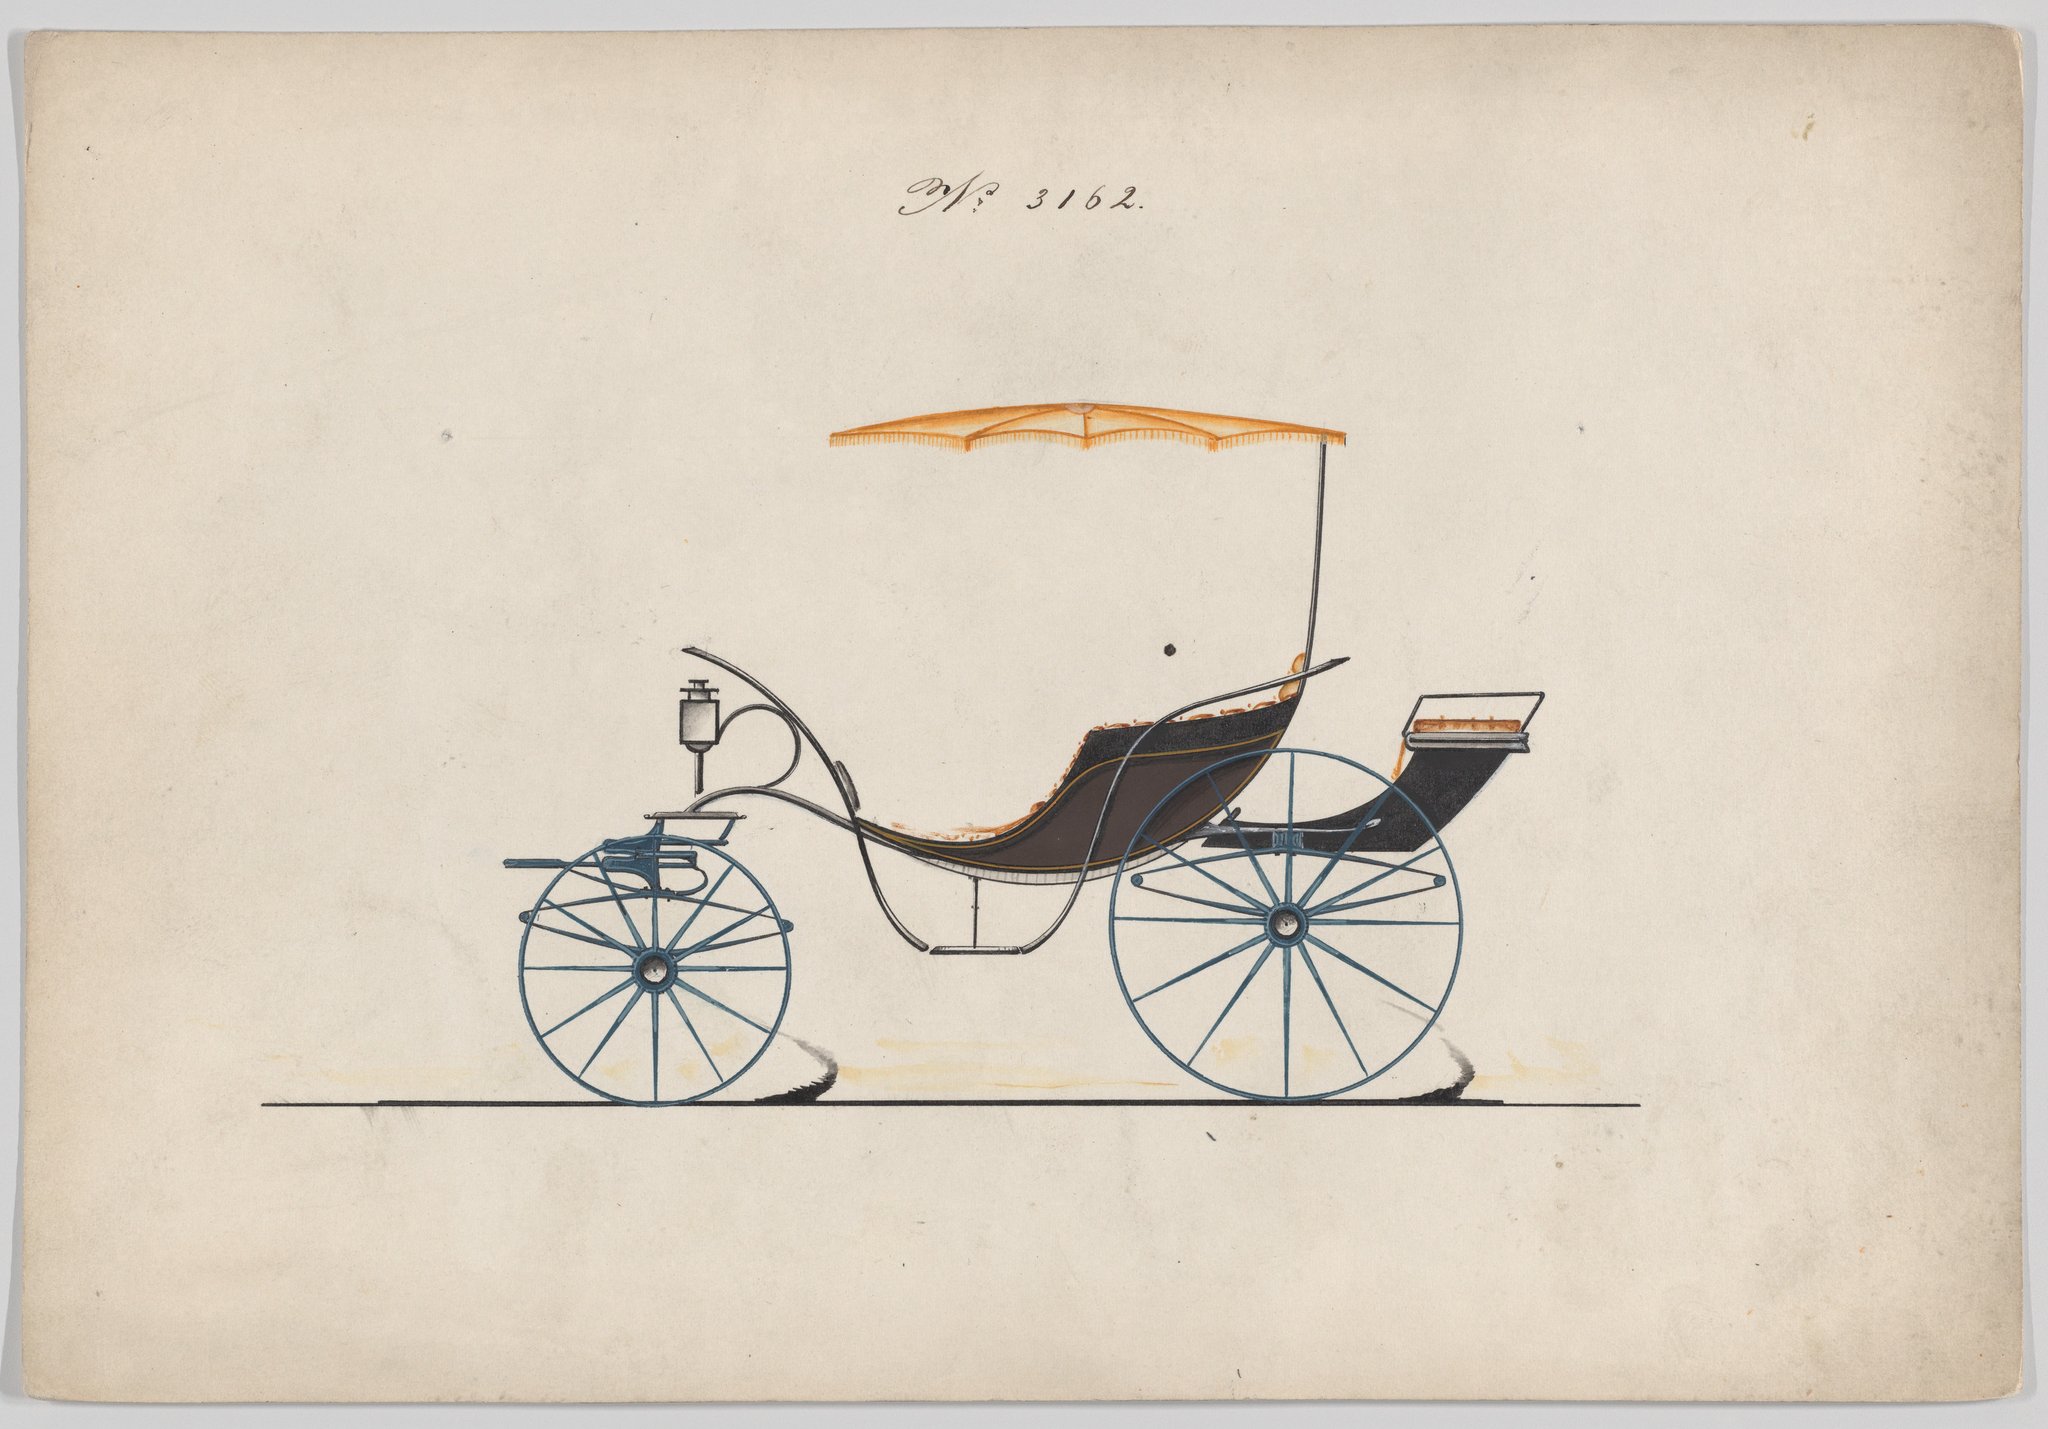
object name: drawing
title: Design for Pony Phaeton, no. 3162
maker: brewster & co.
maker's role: manufacturer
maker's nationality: american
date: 1875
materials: gouache, ink, watercolor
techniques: pen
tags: carriages